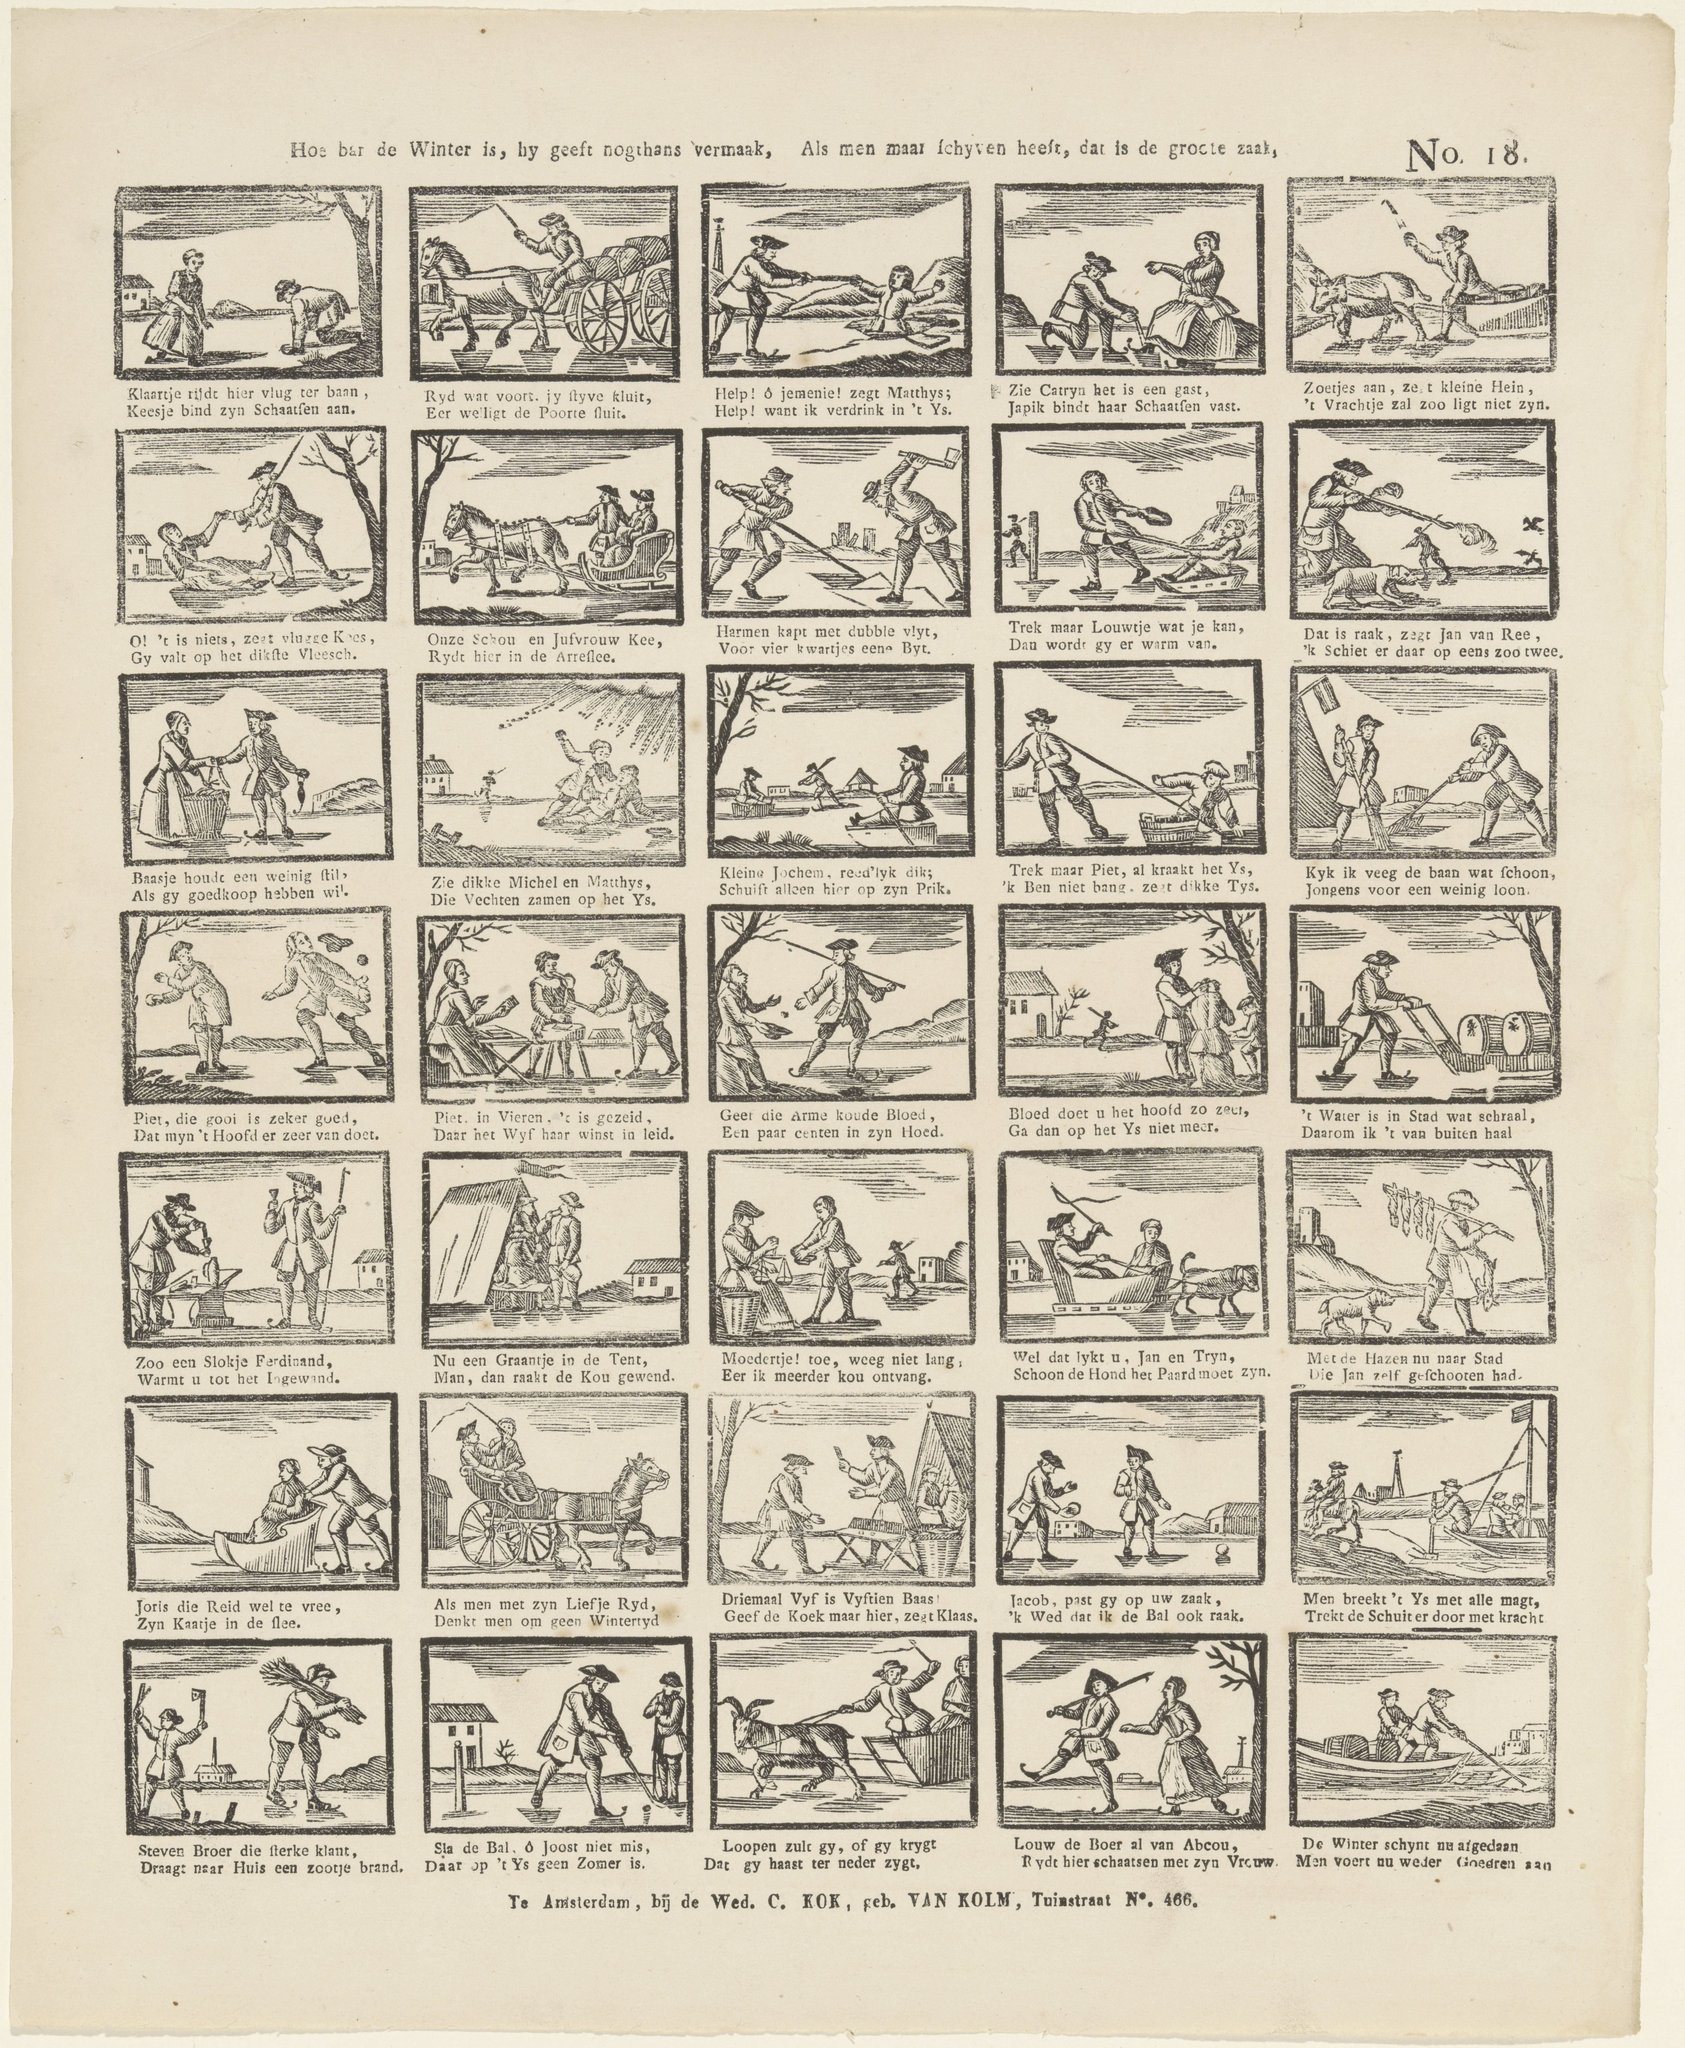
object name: popular print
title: Hoe bar de winter is, hy geeft nogthans vermaak, Als men maar schyven heeft, dat is de groote zaak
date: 1842-1866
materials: paper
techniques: letterpress printing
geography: amsterdam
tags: winter sports, skates (winter sports), sledge, sleigh (winter sports)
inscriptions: collector's mark: Lugt 2760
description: Blad met 35 voorstellingen van winterse activiteiten, zoals schaatsen en sleeën. Onder elke voorstelling een tweeregelig vers. Genummerd rechtsboven: No. 18.